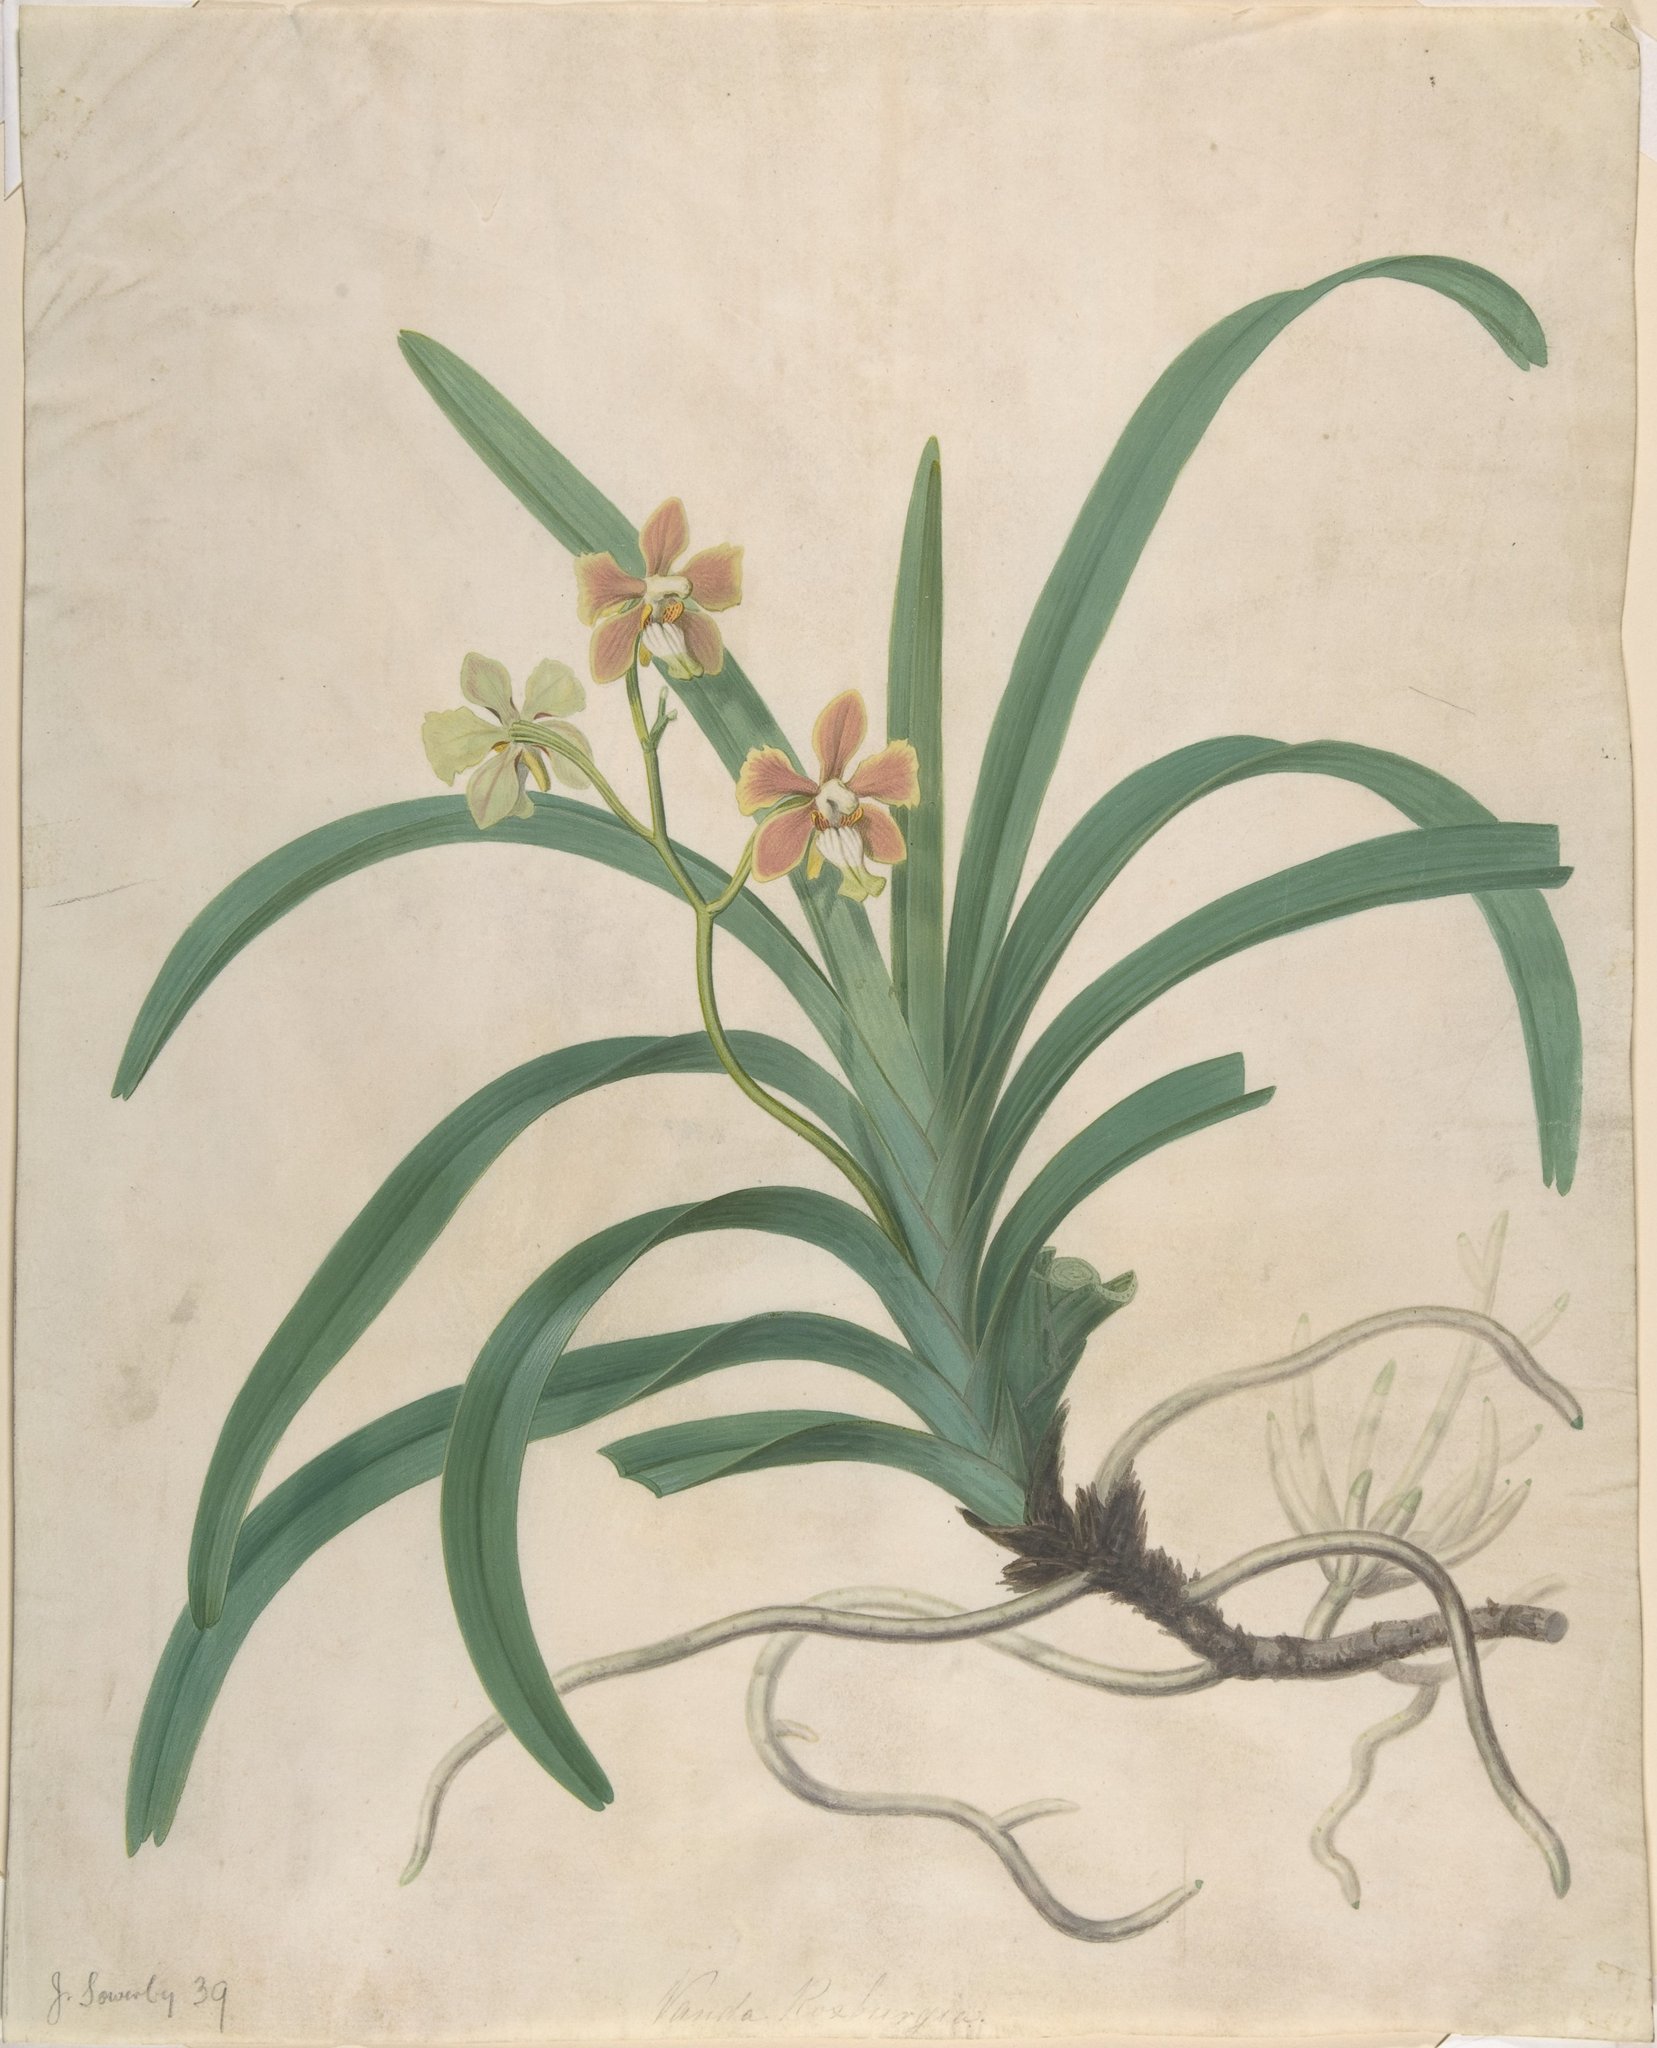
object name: drawing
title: Study of an orchid, "Vanda Roxburgia"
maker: james sowerby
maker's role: artist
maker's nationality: british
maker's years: 1757-1822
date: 1822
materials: gouache, graphite, paper, parchment, watercolor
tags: orchids,leaves